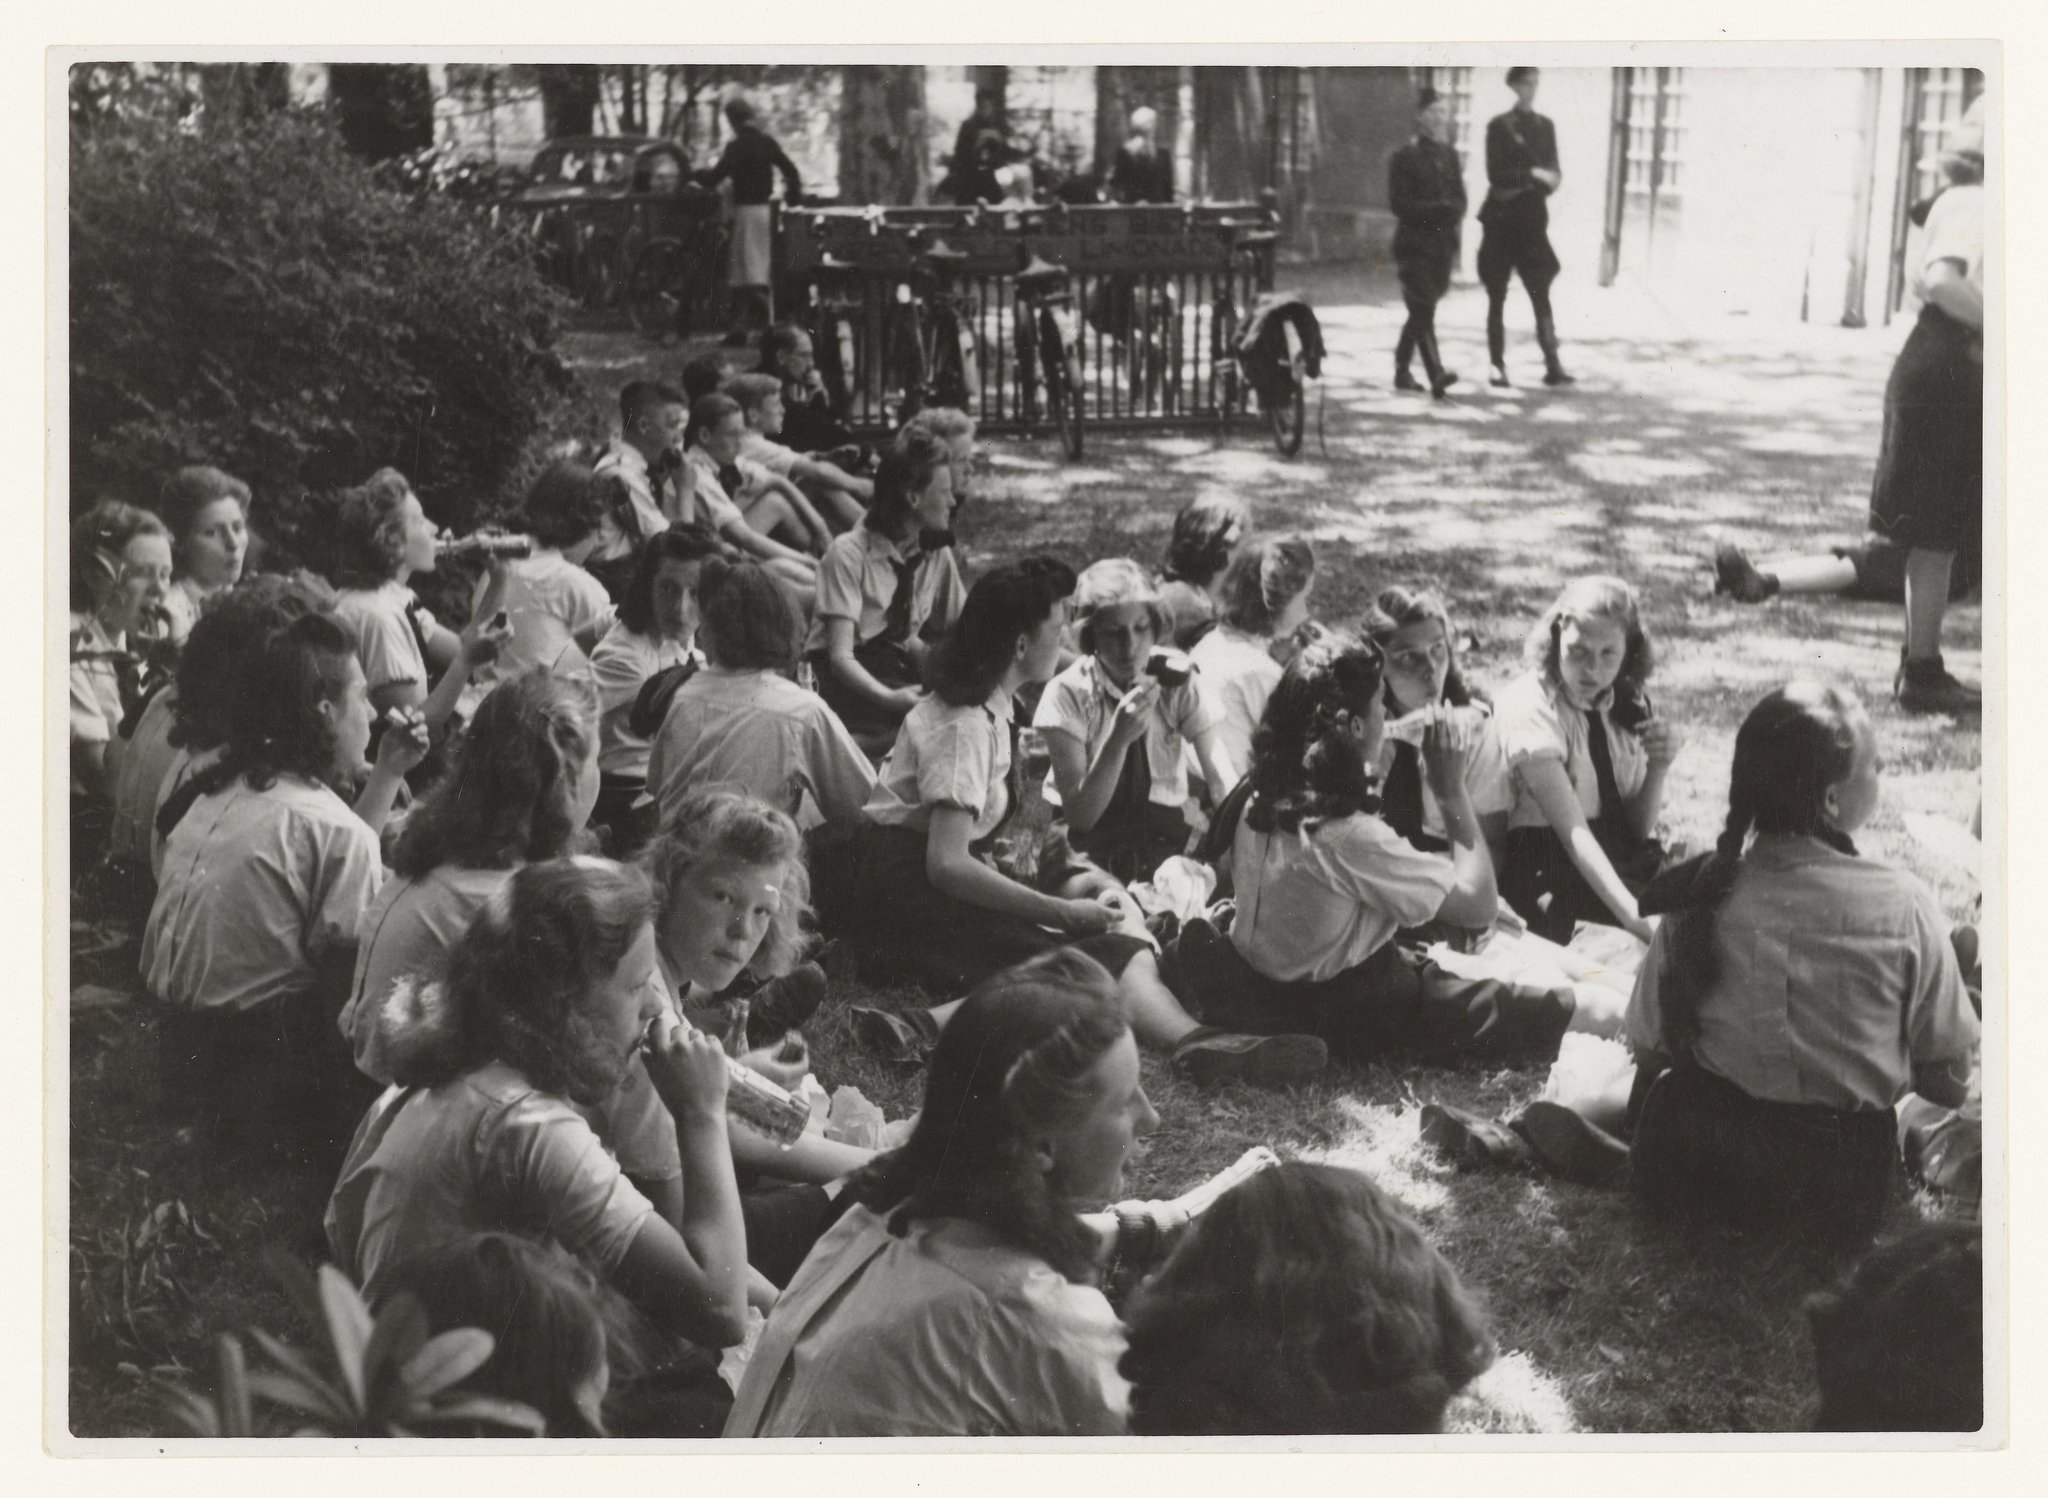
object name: photograph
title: Meisjes van de Jeugdstorm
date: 1934-1943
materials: photographic support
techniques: photography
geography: netherlands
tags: military celebrations, netherlands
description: Meisjes van de Jeugdstorm vermaken zich tijdens een bijeenkomst in de open lucht. Ze zijn aan het eten en drinken. Op de achtergrond twee mannen in uniform, een fietsenrek en huizen.